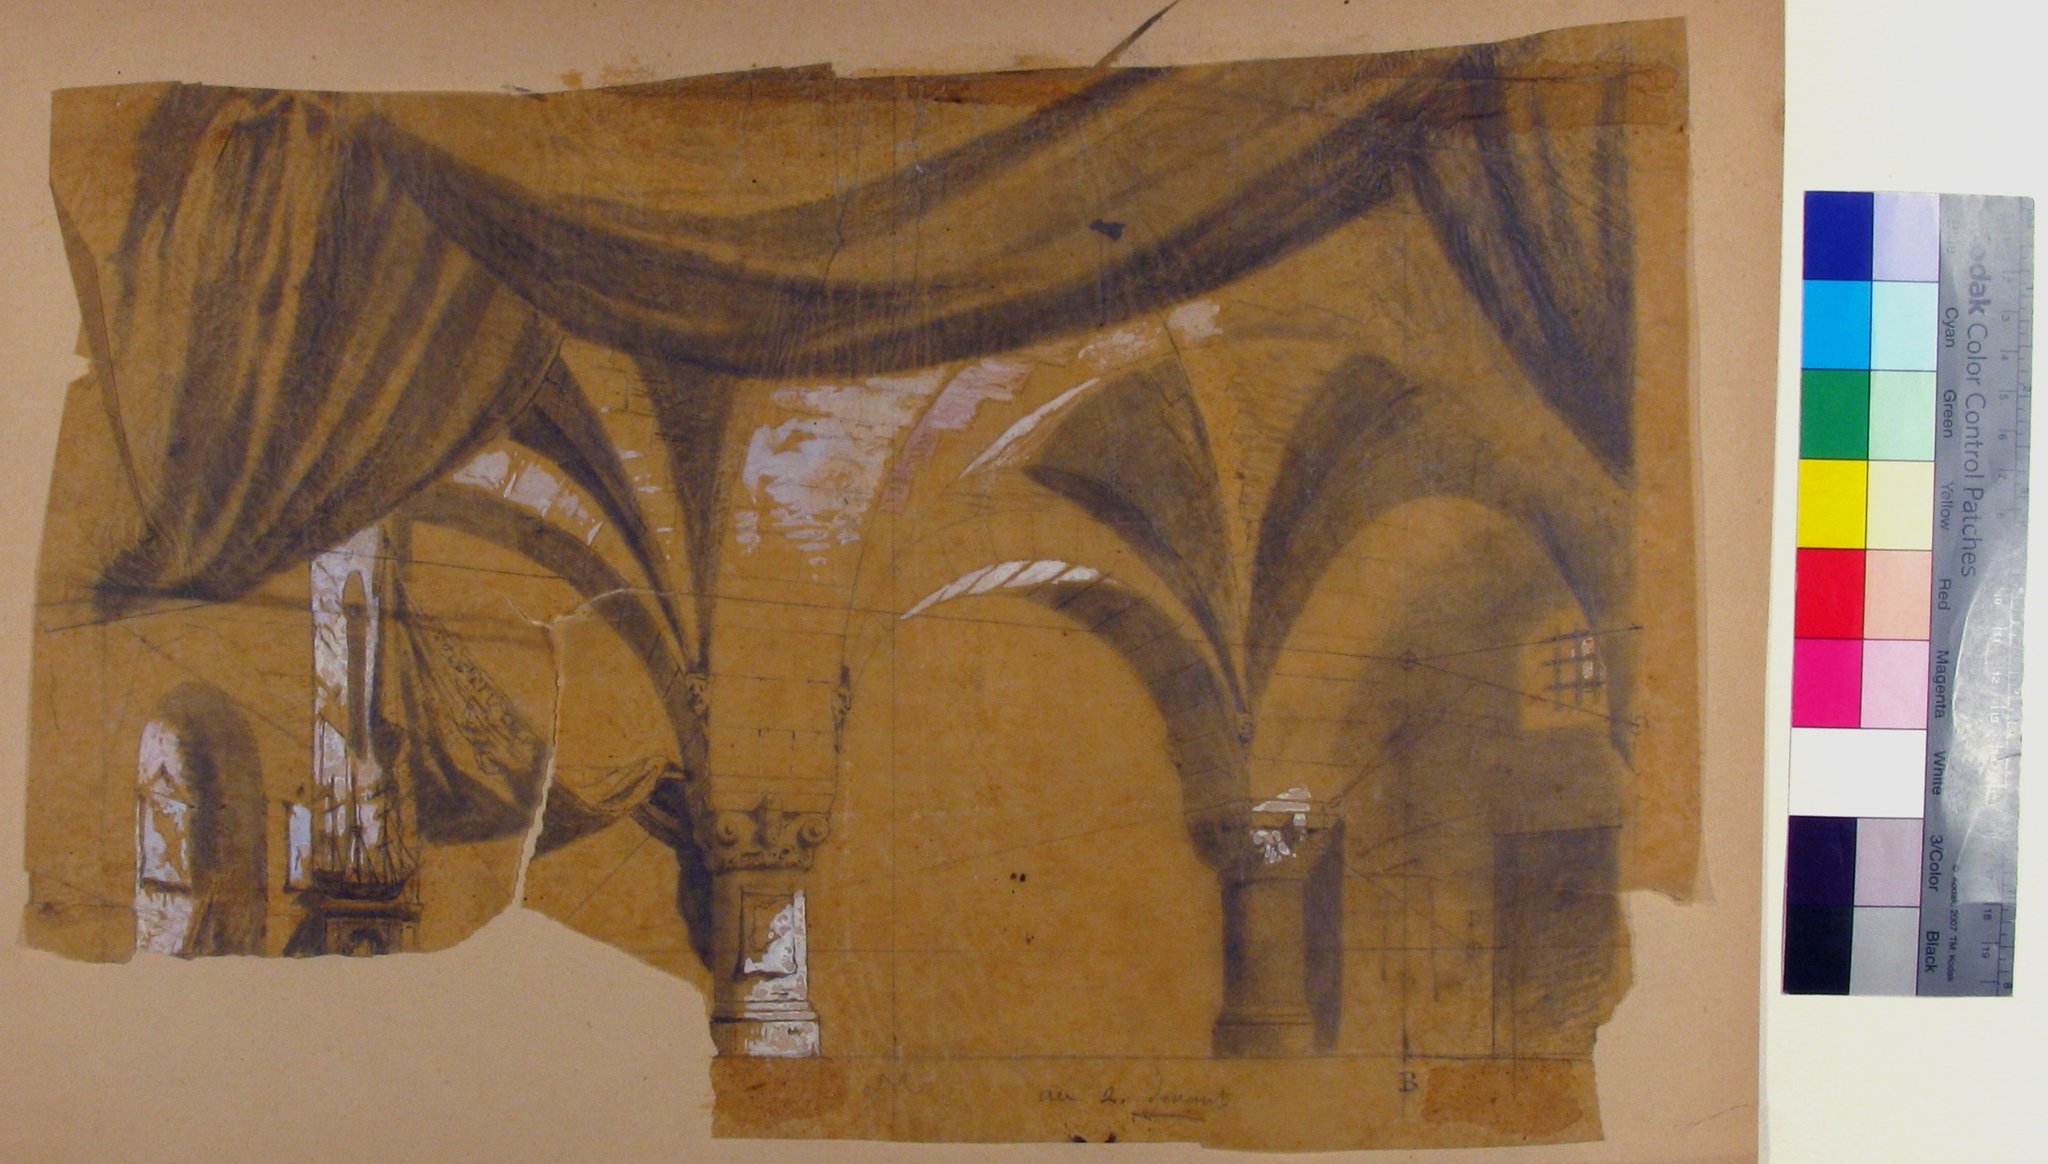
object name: drawing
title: Design for a Stage Set at the Opéra, Paris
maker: eugène cicéri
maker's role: artist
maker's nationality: french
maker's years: 1813-1890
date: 1830-1890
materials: gouache, graphite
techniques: heightening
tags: theatre,stage design